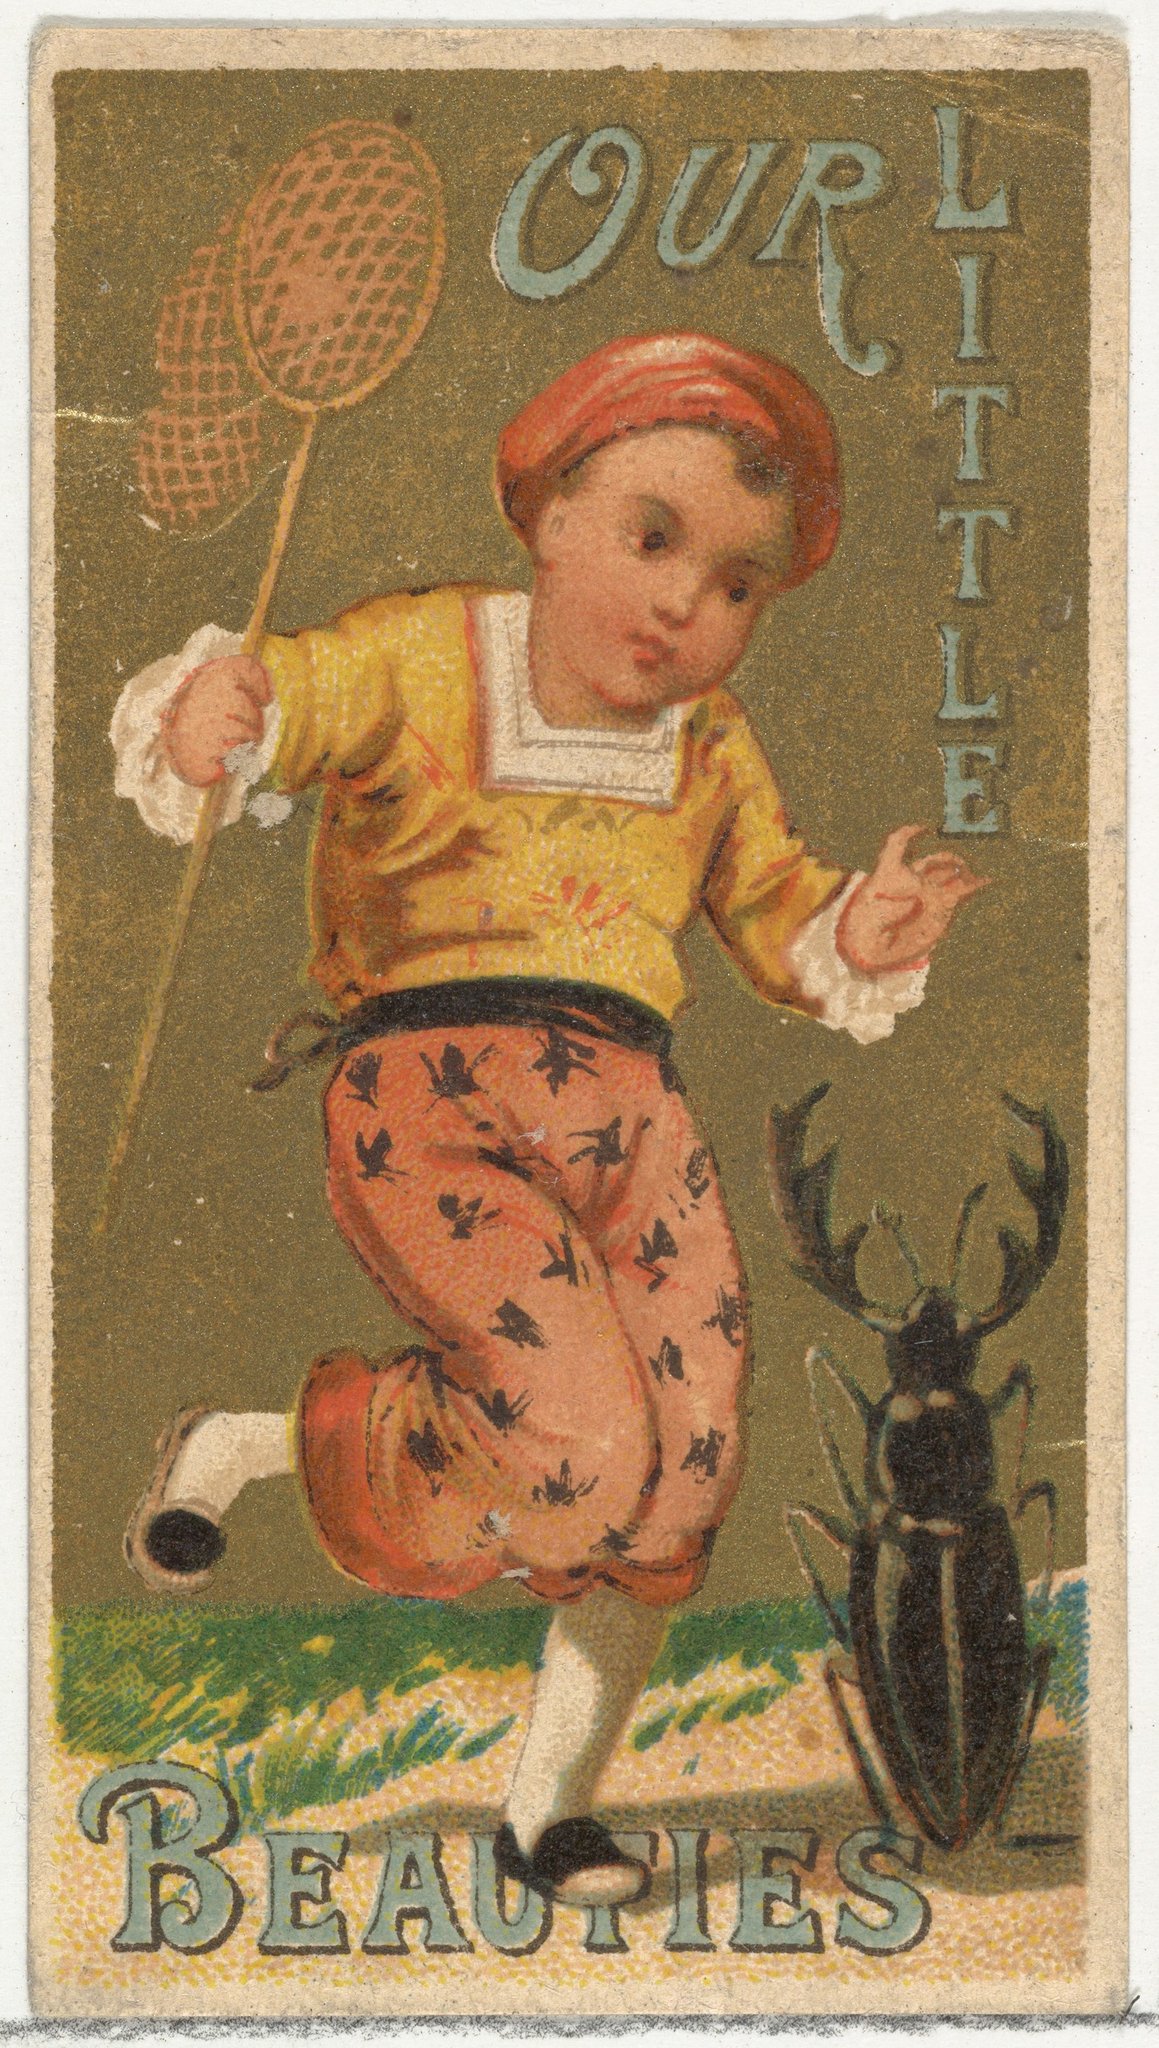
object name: print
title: From the Girls and Children series (N58) promoting Our Little Beauties Cigarettes for Allen & Ginter brand tobacco products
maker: allen & ginter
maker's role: publisher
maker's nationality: american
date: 1887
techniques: color lithograph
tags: girls,insects